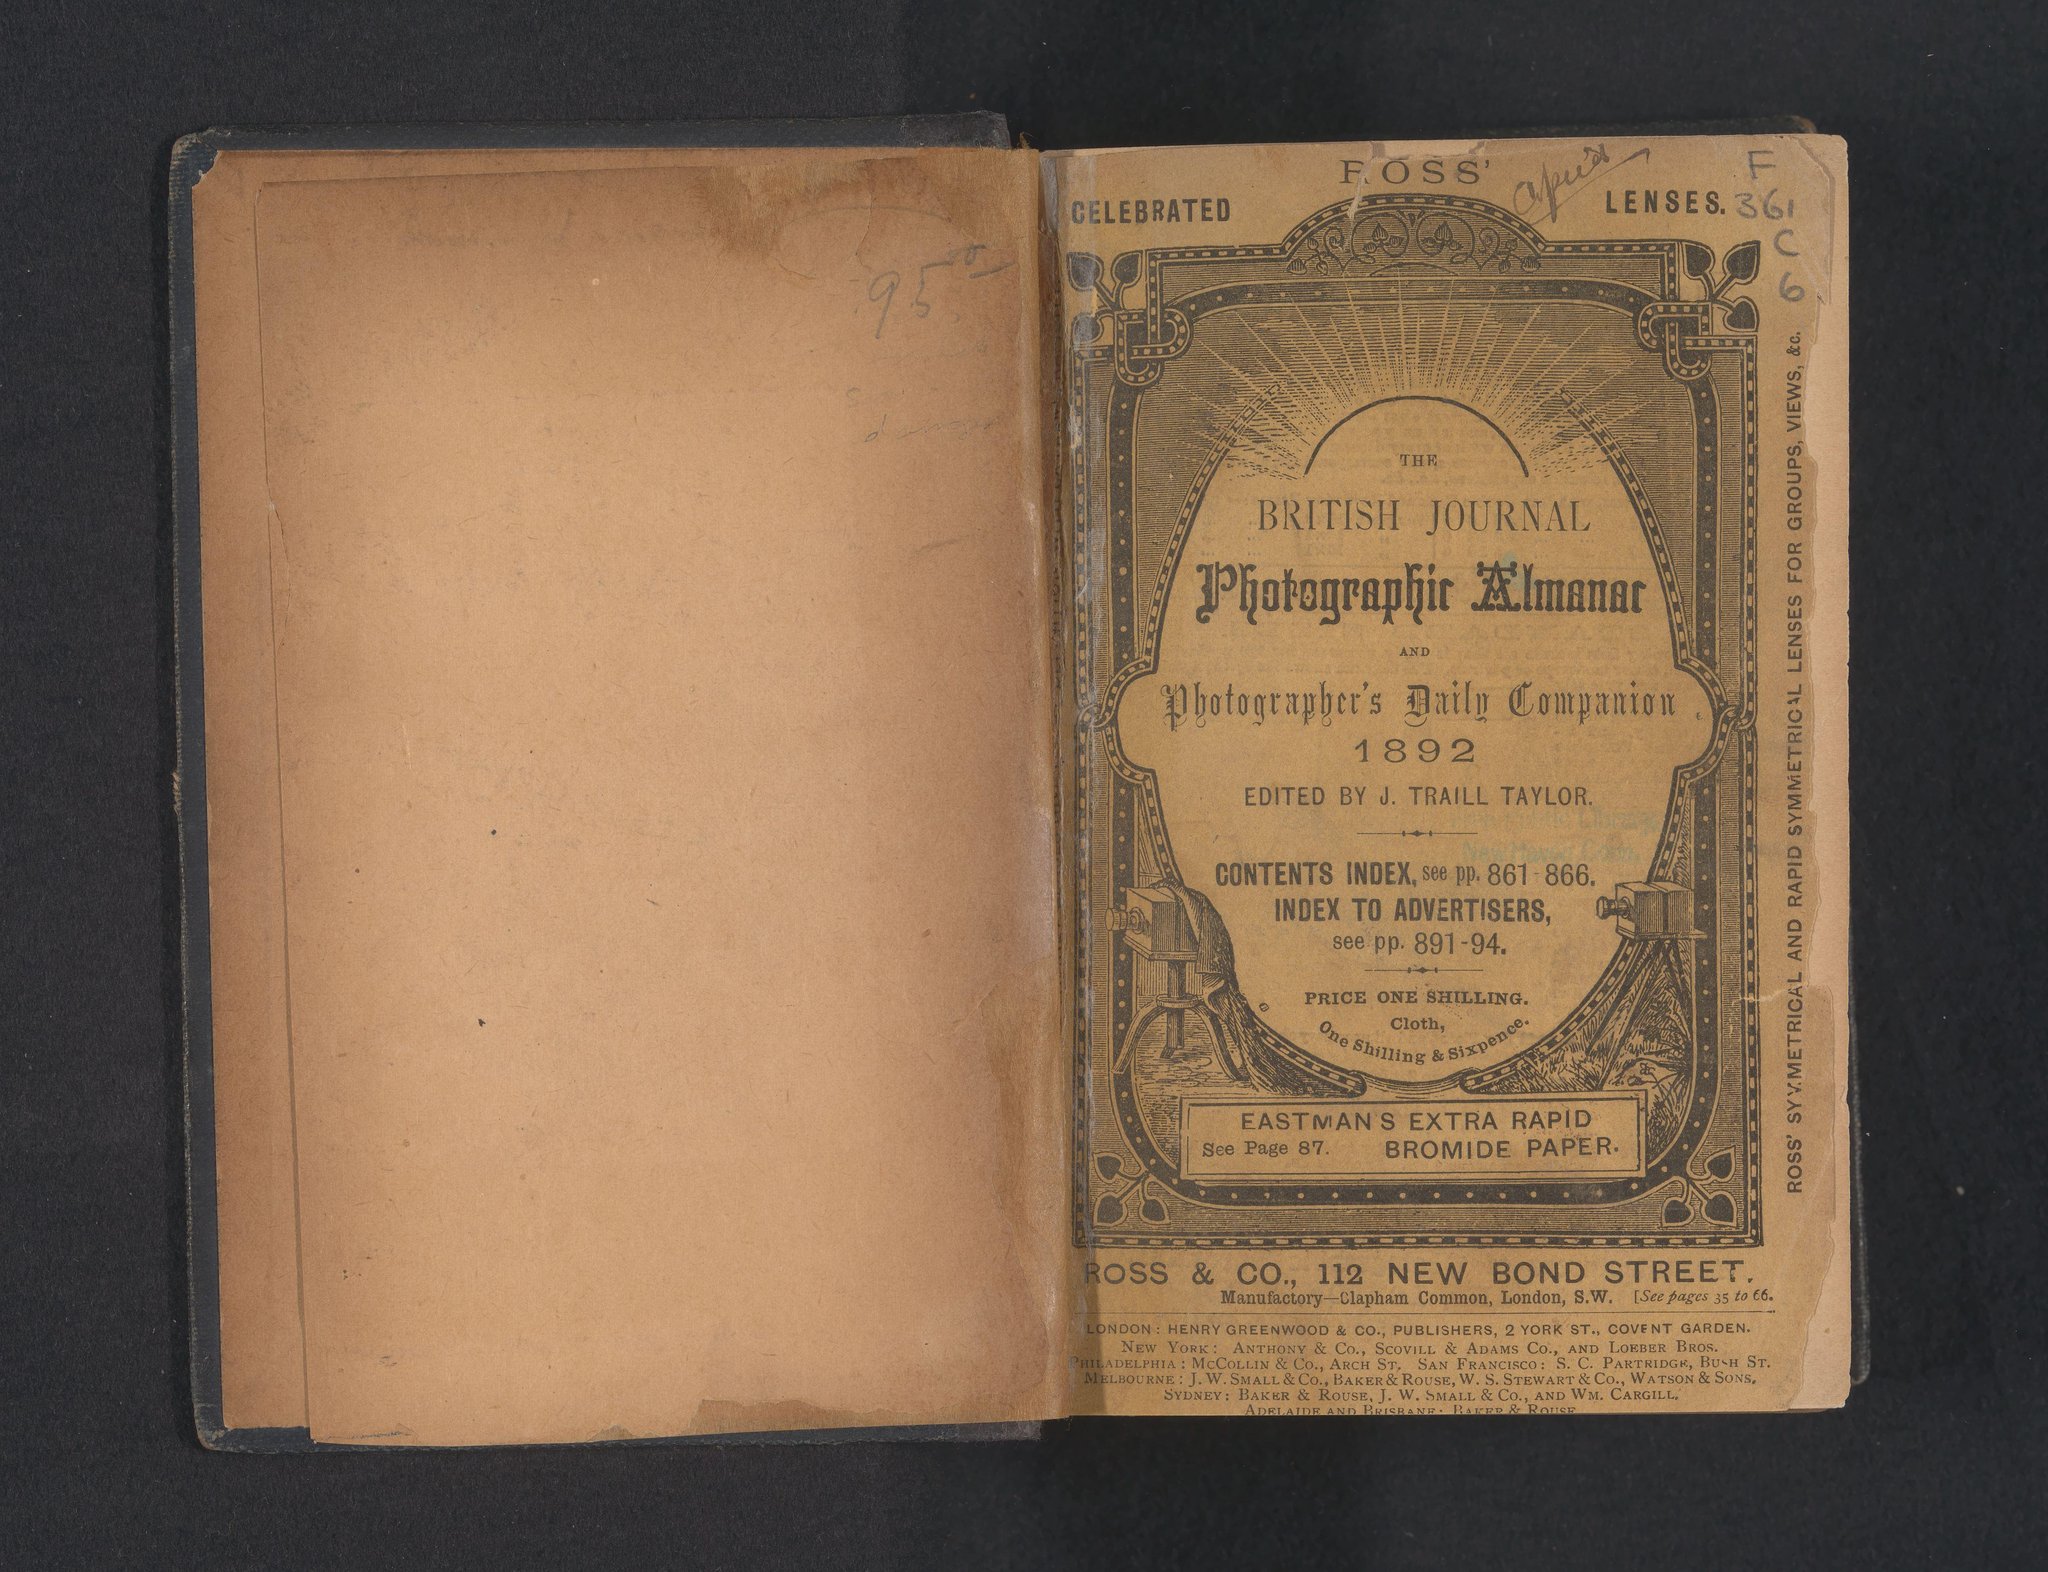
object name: book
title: The British journal photographic almanac and photographer's daily companion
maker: james traill taylor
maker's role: redacteur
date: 1859-1861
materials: paper, photographic support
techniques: photograph, gelatin silver print, printing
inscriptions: date: ‘MAY 1994’, annotation: ‘95-’, collector's mark: ‘Free Pulic Library of New Haven’